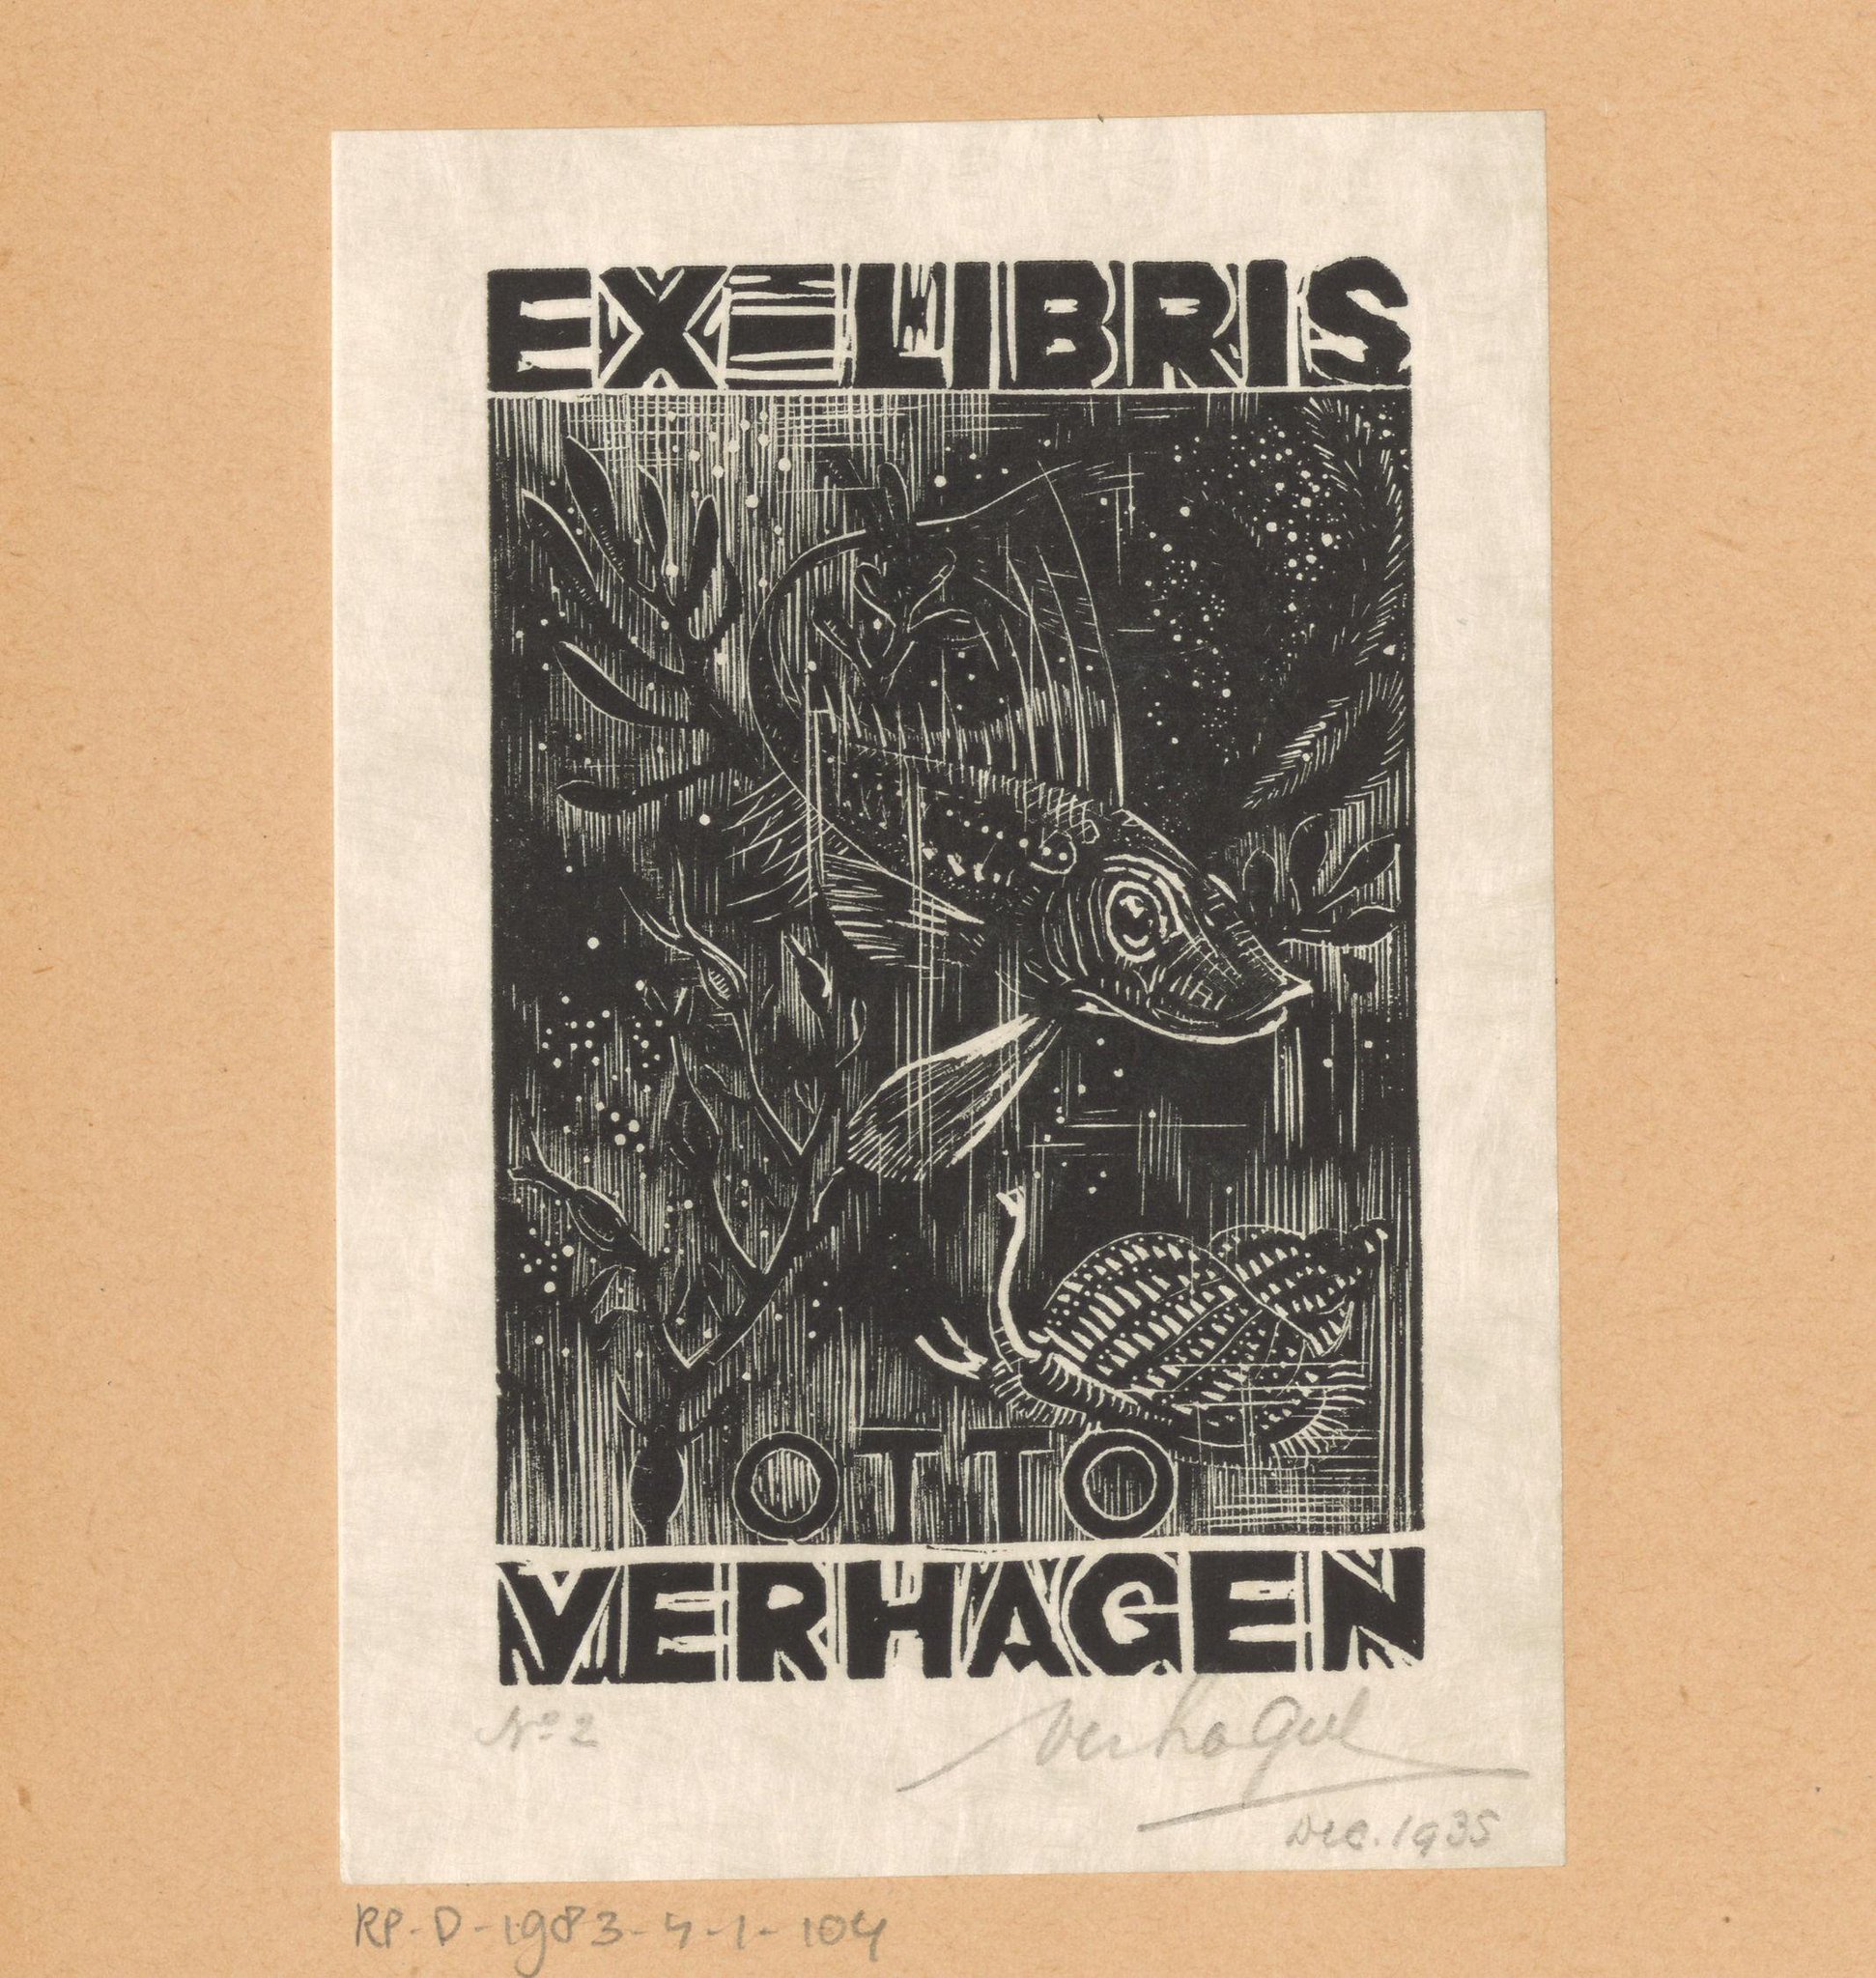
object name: bookplate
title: Ex libris van Otto Verhagen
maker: otto verhagen (i)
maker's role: draughtsman, print maker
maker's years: 1885-1951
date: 1935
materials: paper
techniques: woodcut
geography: netherlands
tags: the hague, print maker, draughtsman, otto verhagen (i), fishes, molluscs: snail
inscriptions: inscription: ‘Druk op Jap. papier super-nacré [?]’, signature, date and inscription: ‘No. 2 Verhagen/ Dec. 1935’, inscription: ‘Houtsnede (Kops-perenhout) (...) New York - 1950.’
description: Afgebeeld zijn diepzee fauna en flora. De prent is afgebeeld en besproken in D. Giltay Veth, "Dutch book plates", New York, 1950.